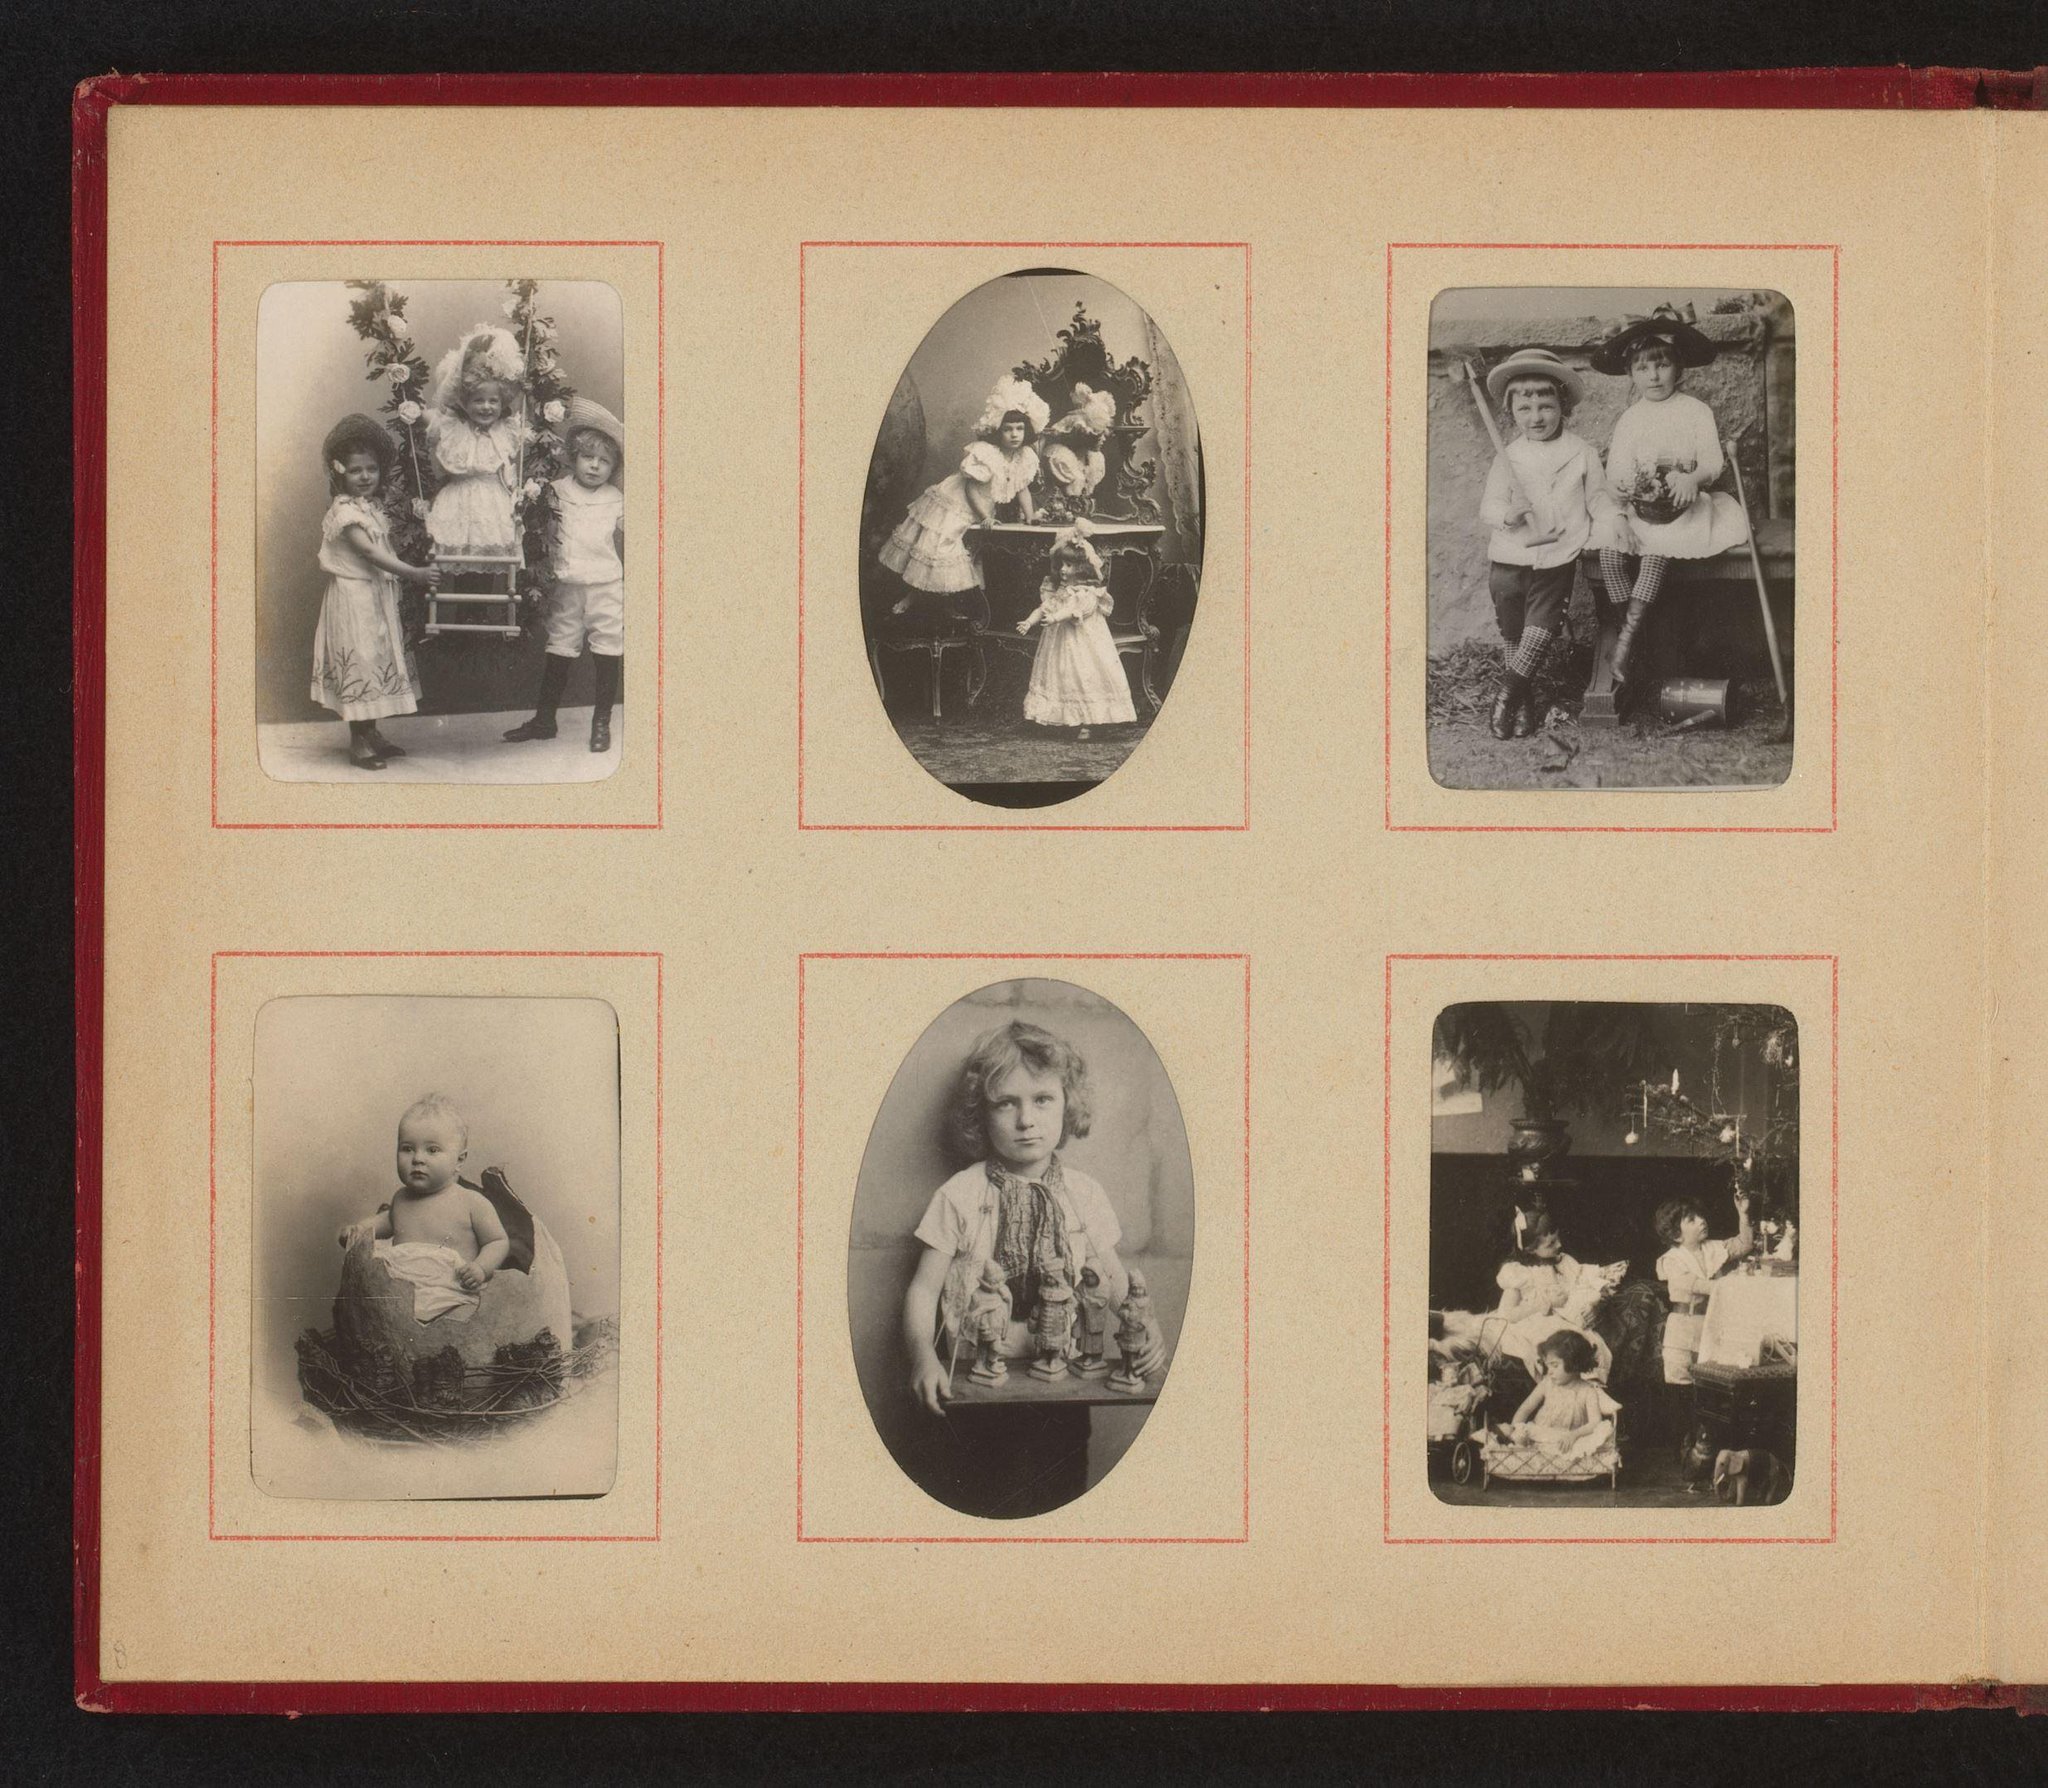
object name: album leaf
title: Kinderportretten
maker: Anonymous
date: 1880-1920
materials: photographic support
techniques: gelatin silver print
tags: studio requisites ~ photographer, child, historical persons, trade games, imitative games, imitating adults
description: Zes portretten van kinderen, waaronder een van een baby in een ei en een meisje op een schommel. Deze pagina maakt deel uit van een album.